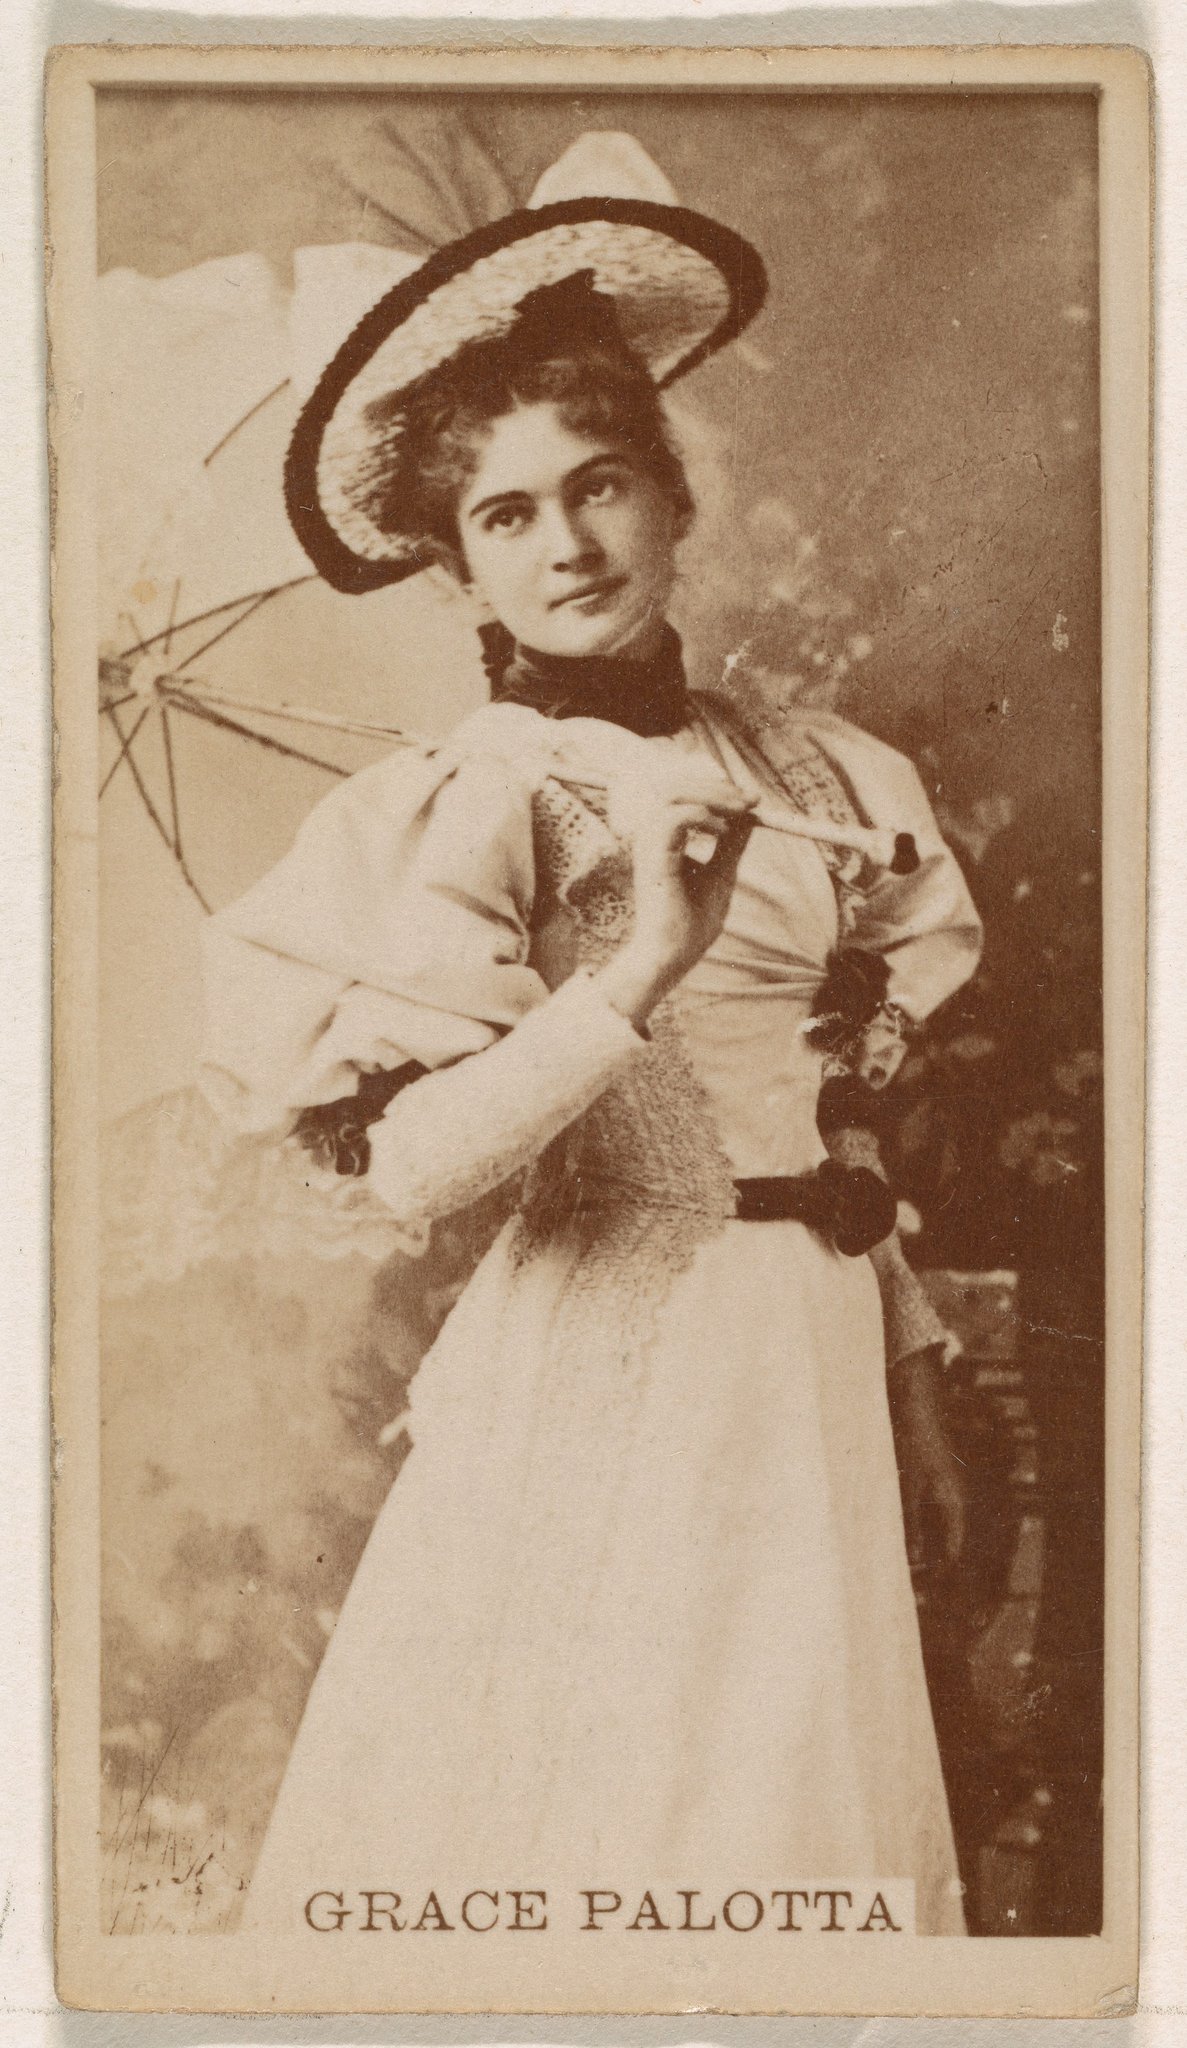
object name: photograph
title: Grace Palotta, from the Actresses series (N245) issued by Kinney Brothers to promote Sweet Caporal Cigarettes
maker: kinney brothers tobacco company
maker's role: publisher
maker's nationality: american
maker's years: 1869-2011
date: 1890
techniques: albumen silver print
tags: portraits,women,actresses